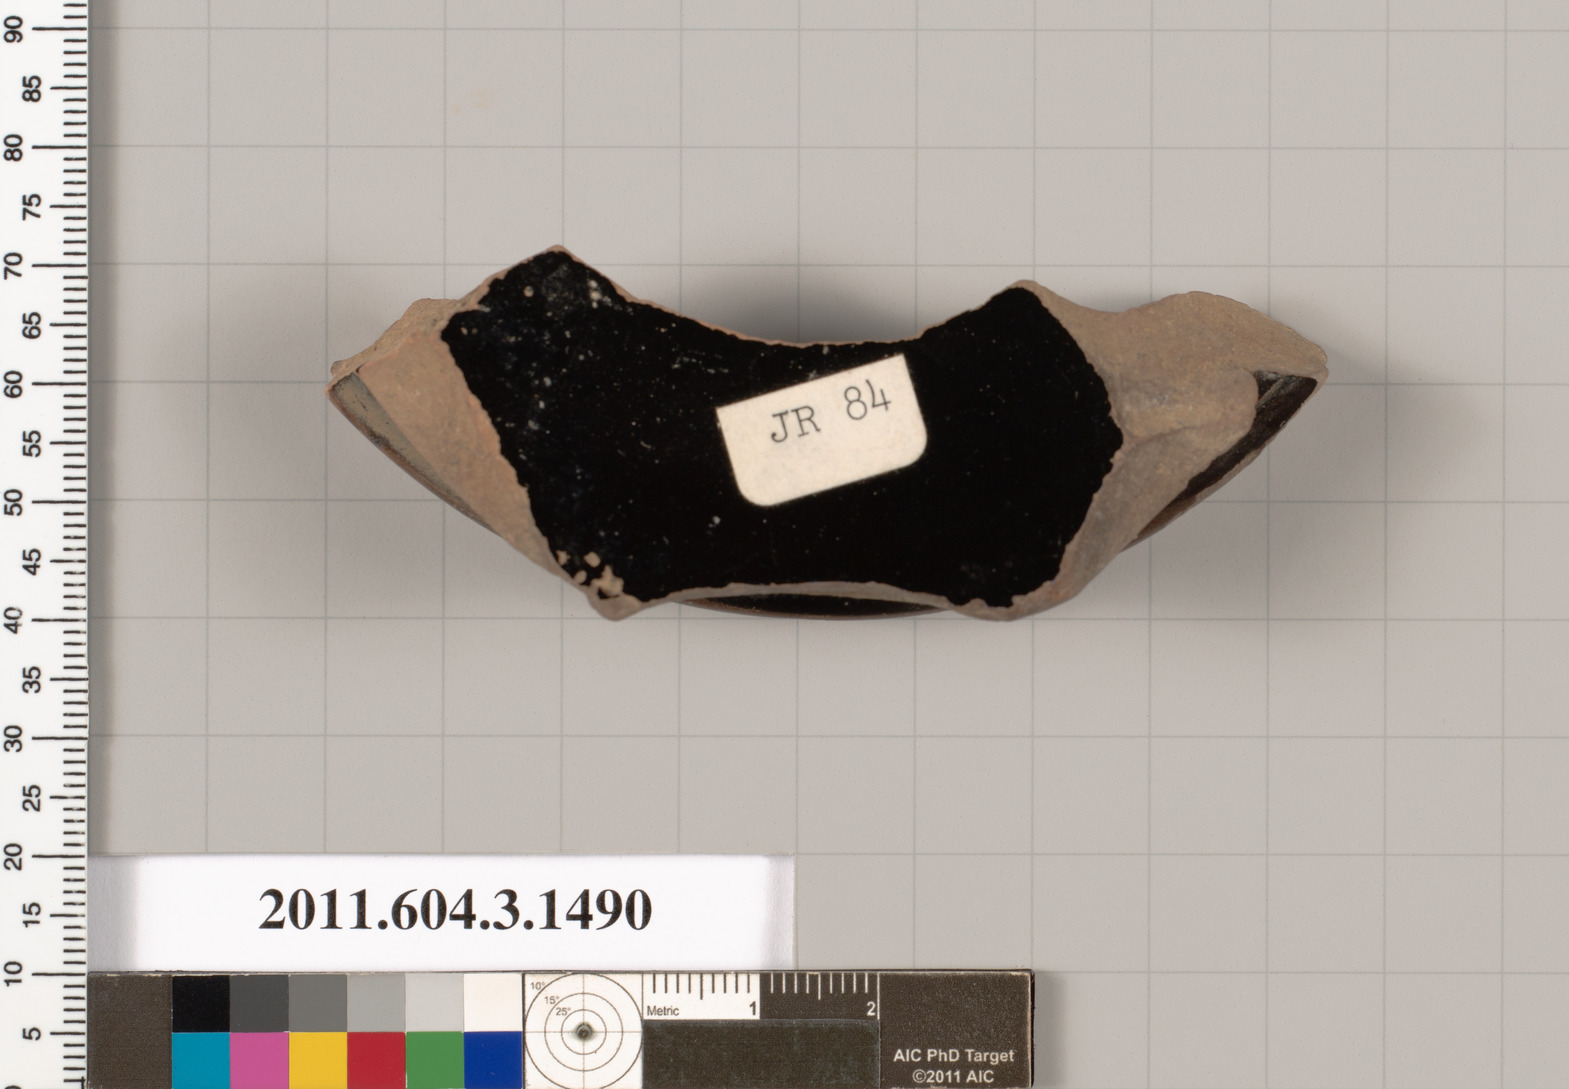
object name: skyphos fragment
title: Terracotta fragment of a skyphos (deep drinking cup)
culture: greek, attic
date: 600-401 BCE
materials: terracotta